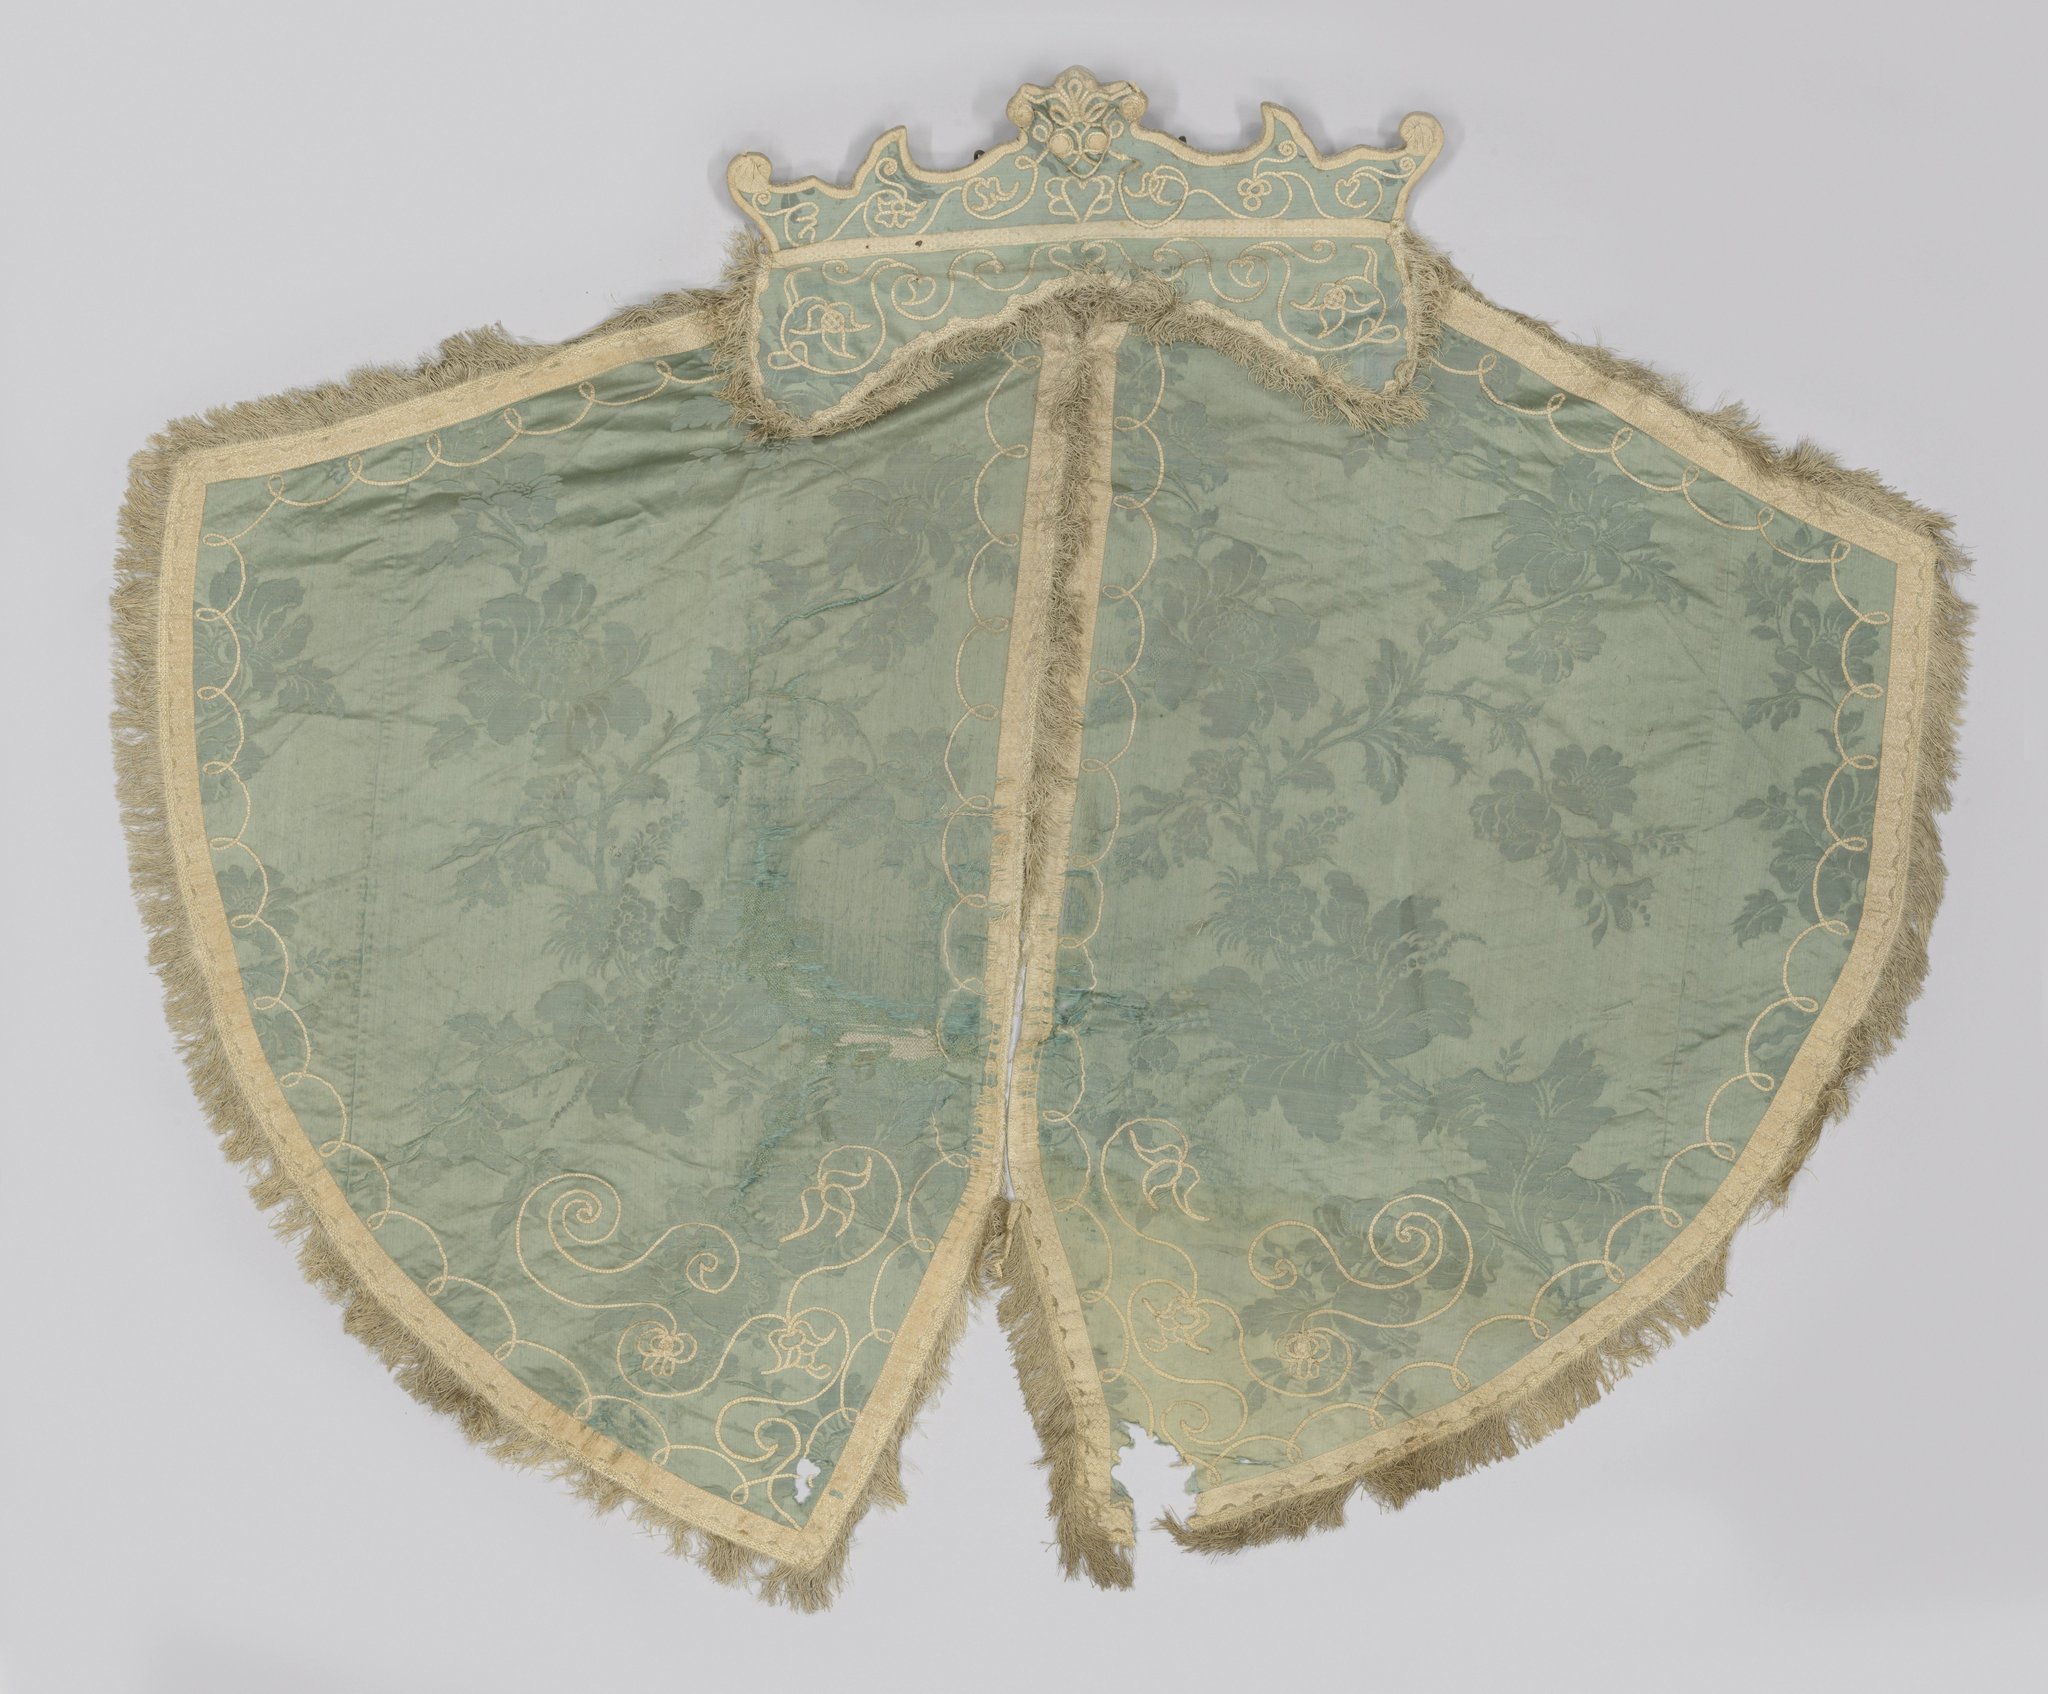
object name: bassinet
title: Wiegenkleed en lambrekijn van mandwieg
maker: Anonymous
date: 1685-1700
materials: silk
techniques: damask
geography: northern netherlands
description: Het blauw damasten wiegenkleed bestaat uit twee delen, beide bevestigd aan een voorgezette lambrekijn.